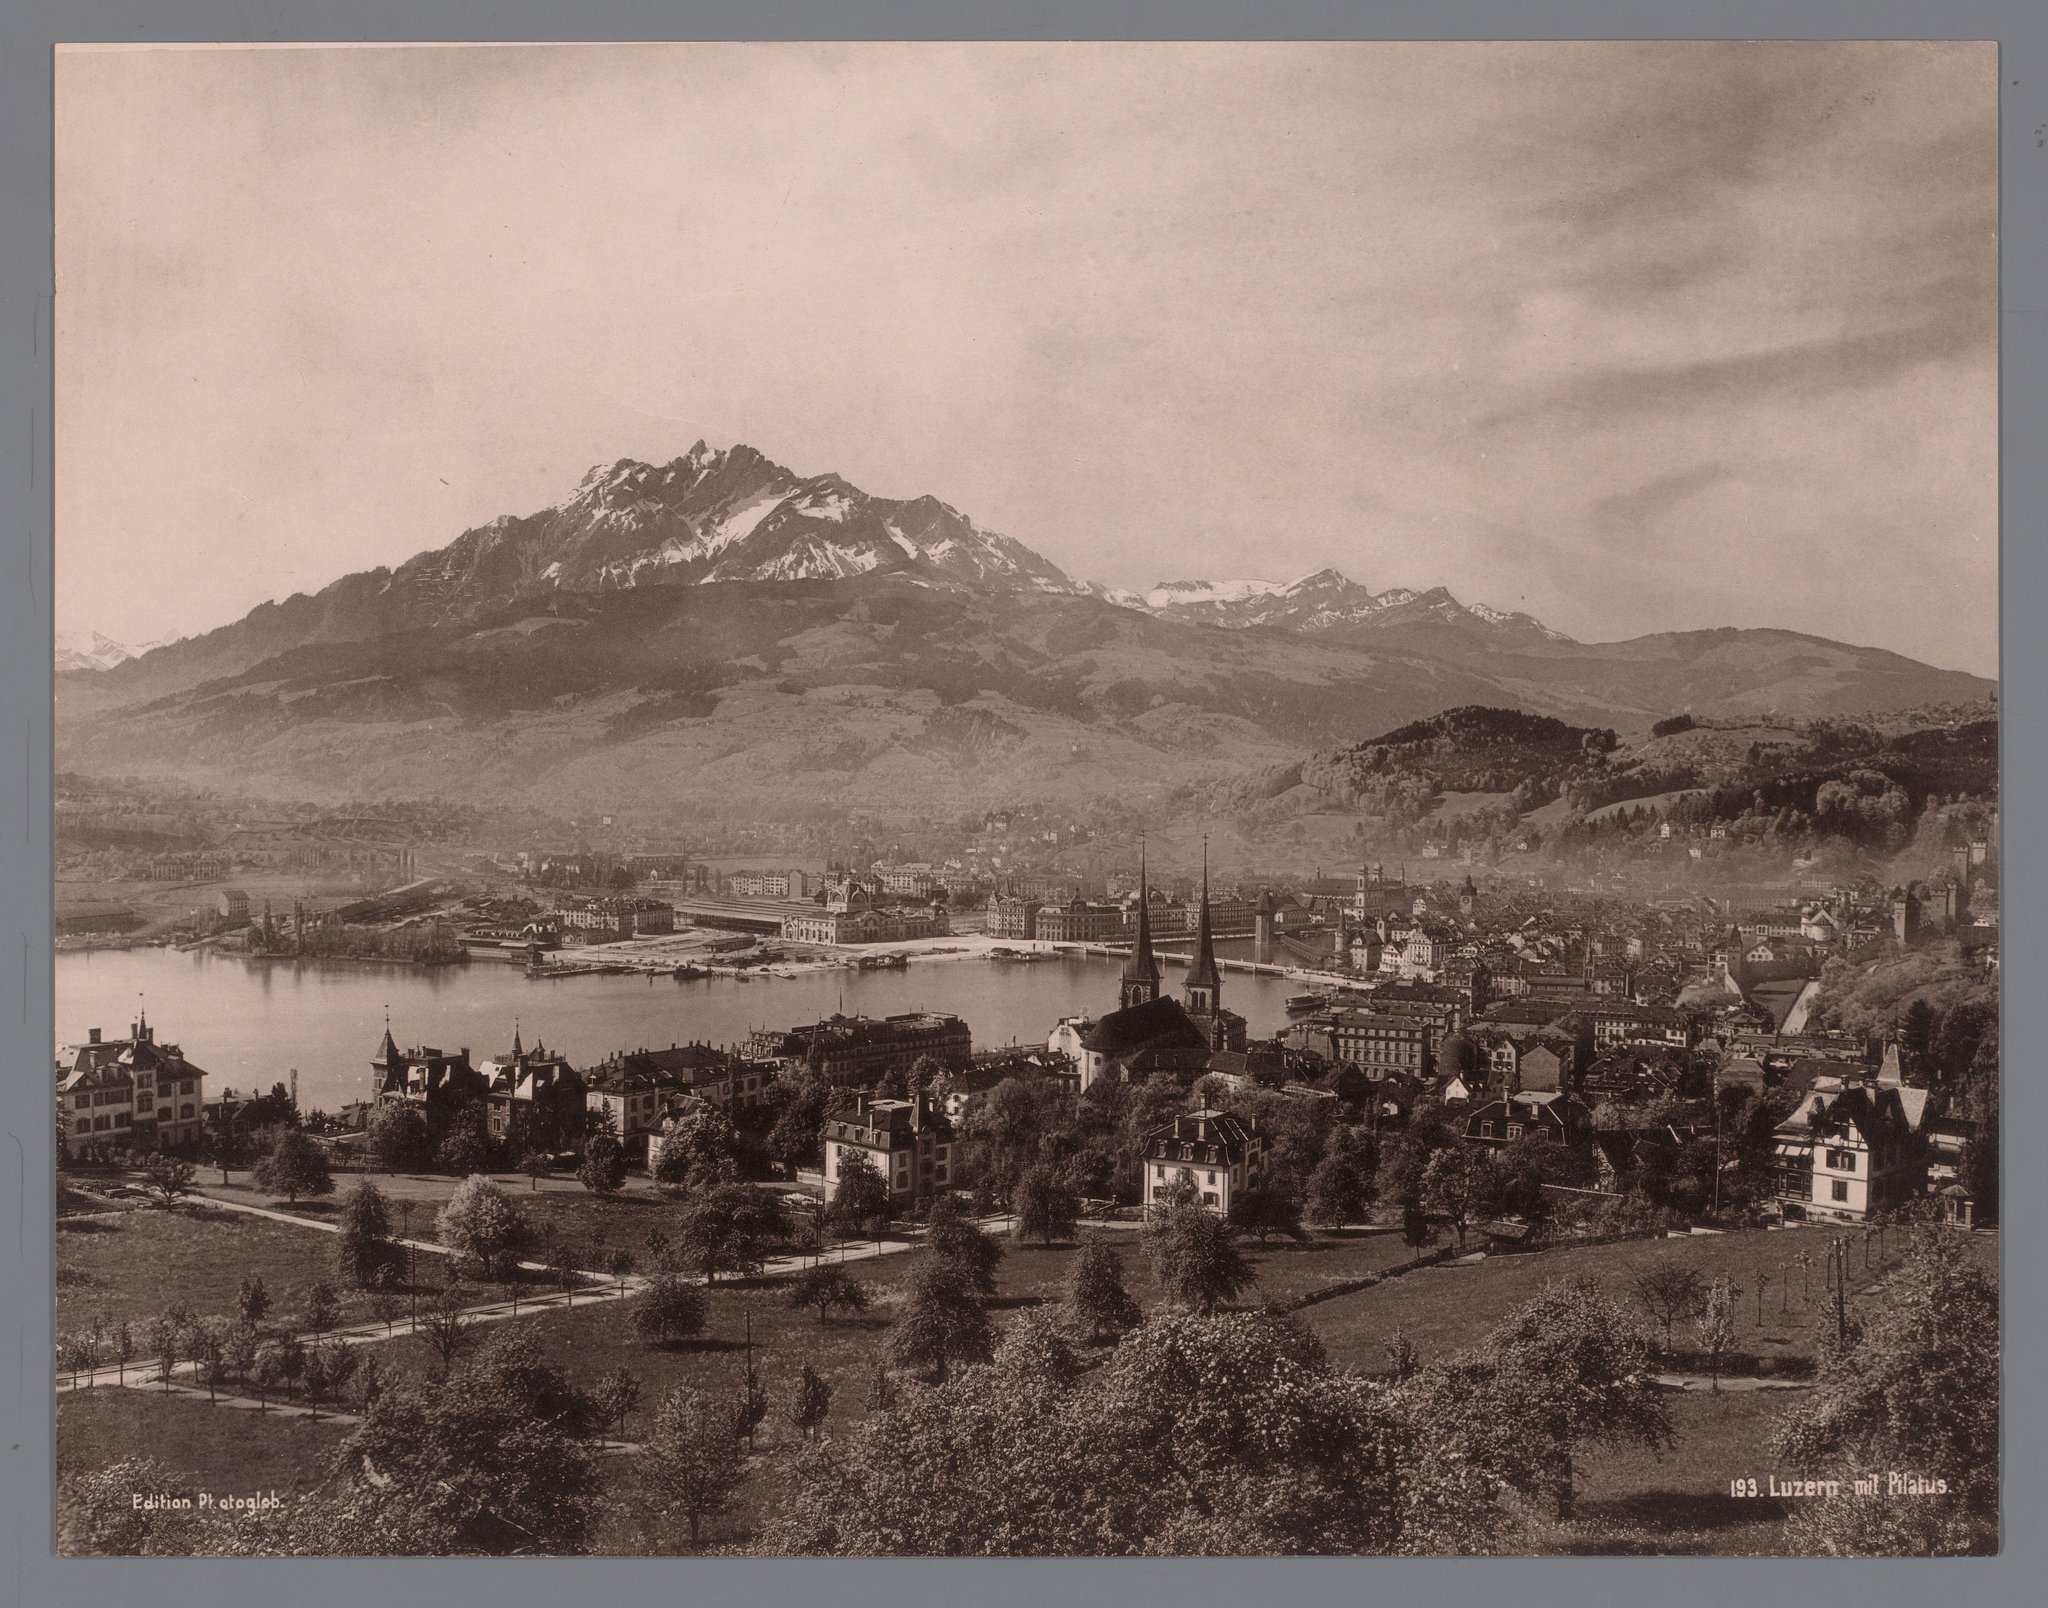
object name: photograph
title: Luzern met berg Pilatus, Zwitserland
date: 1890-1899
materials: paper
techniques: photograph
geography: switzerland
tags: luzern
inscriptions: inscription: ‘Edition Photoglob’, inscription: ‘193. Luzern mit Pilatus’, inscription: ‘2 June [Juni?] 99’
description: De stad Luzern, met berg Pilatus (gelegen aan het Vierwoudstedenmeer), Zwitserland.